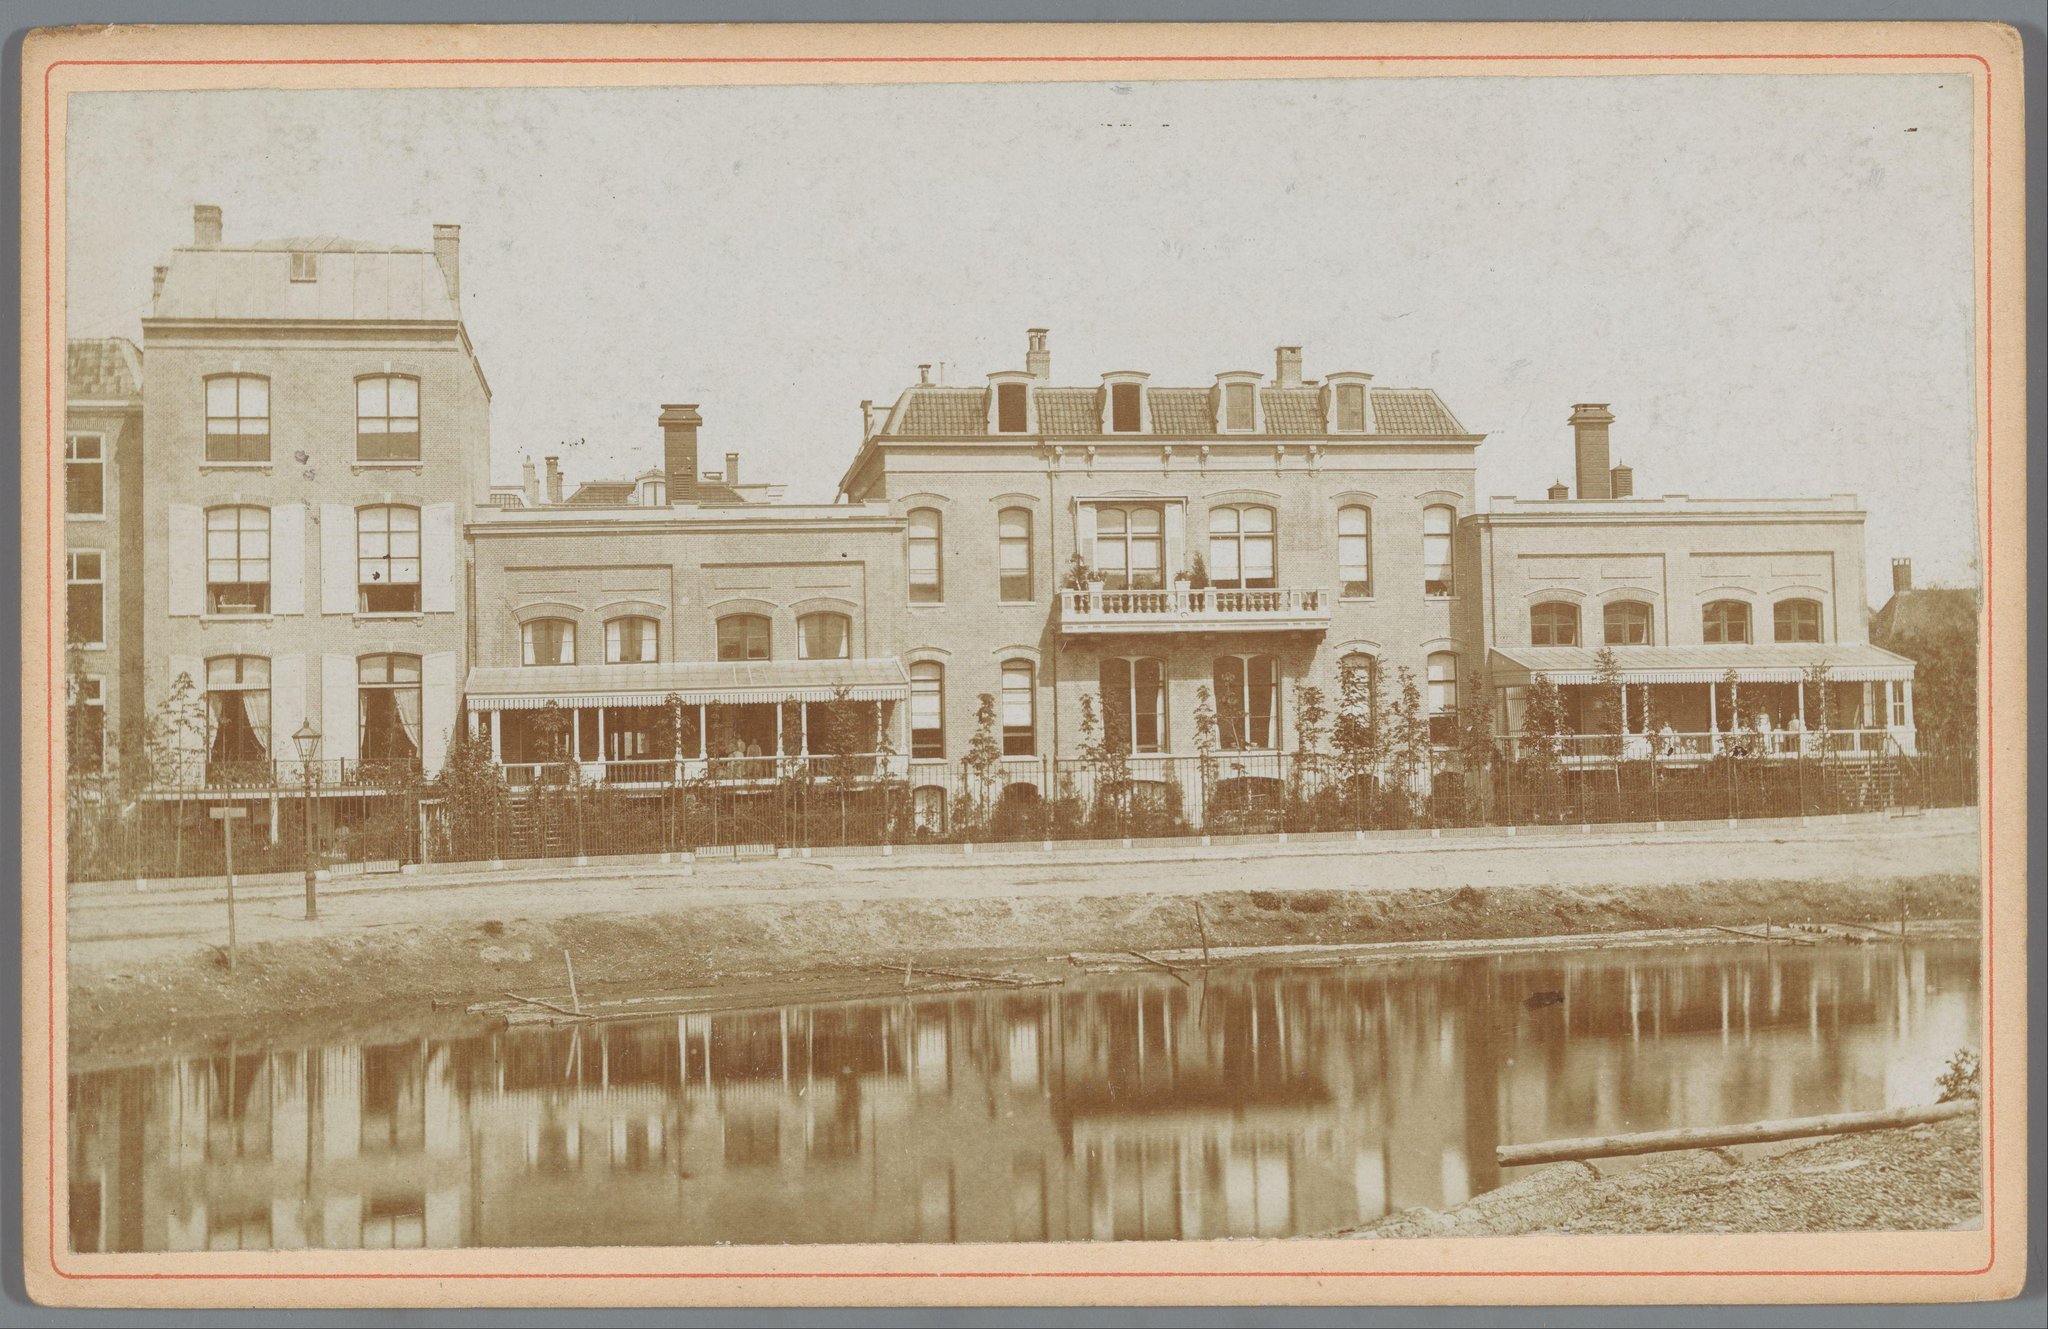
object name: cabinet photograph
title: Gezicht op de achtergevel van het kinderziekenhuis aan de Andrieszkade in Amsterdam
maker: Anonymous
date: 1880-1900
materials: cardboard, photographic support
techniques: collodion silver print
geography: amsterdam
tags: hospital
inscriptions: name: ‘Vosmaer’, number: ‘155’, inscription: ‘Achtergevel van het Kinderziekenhuis aan de Andrieszkade.’